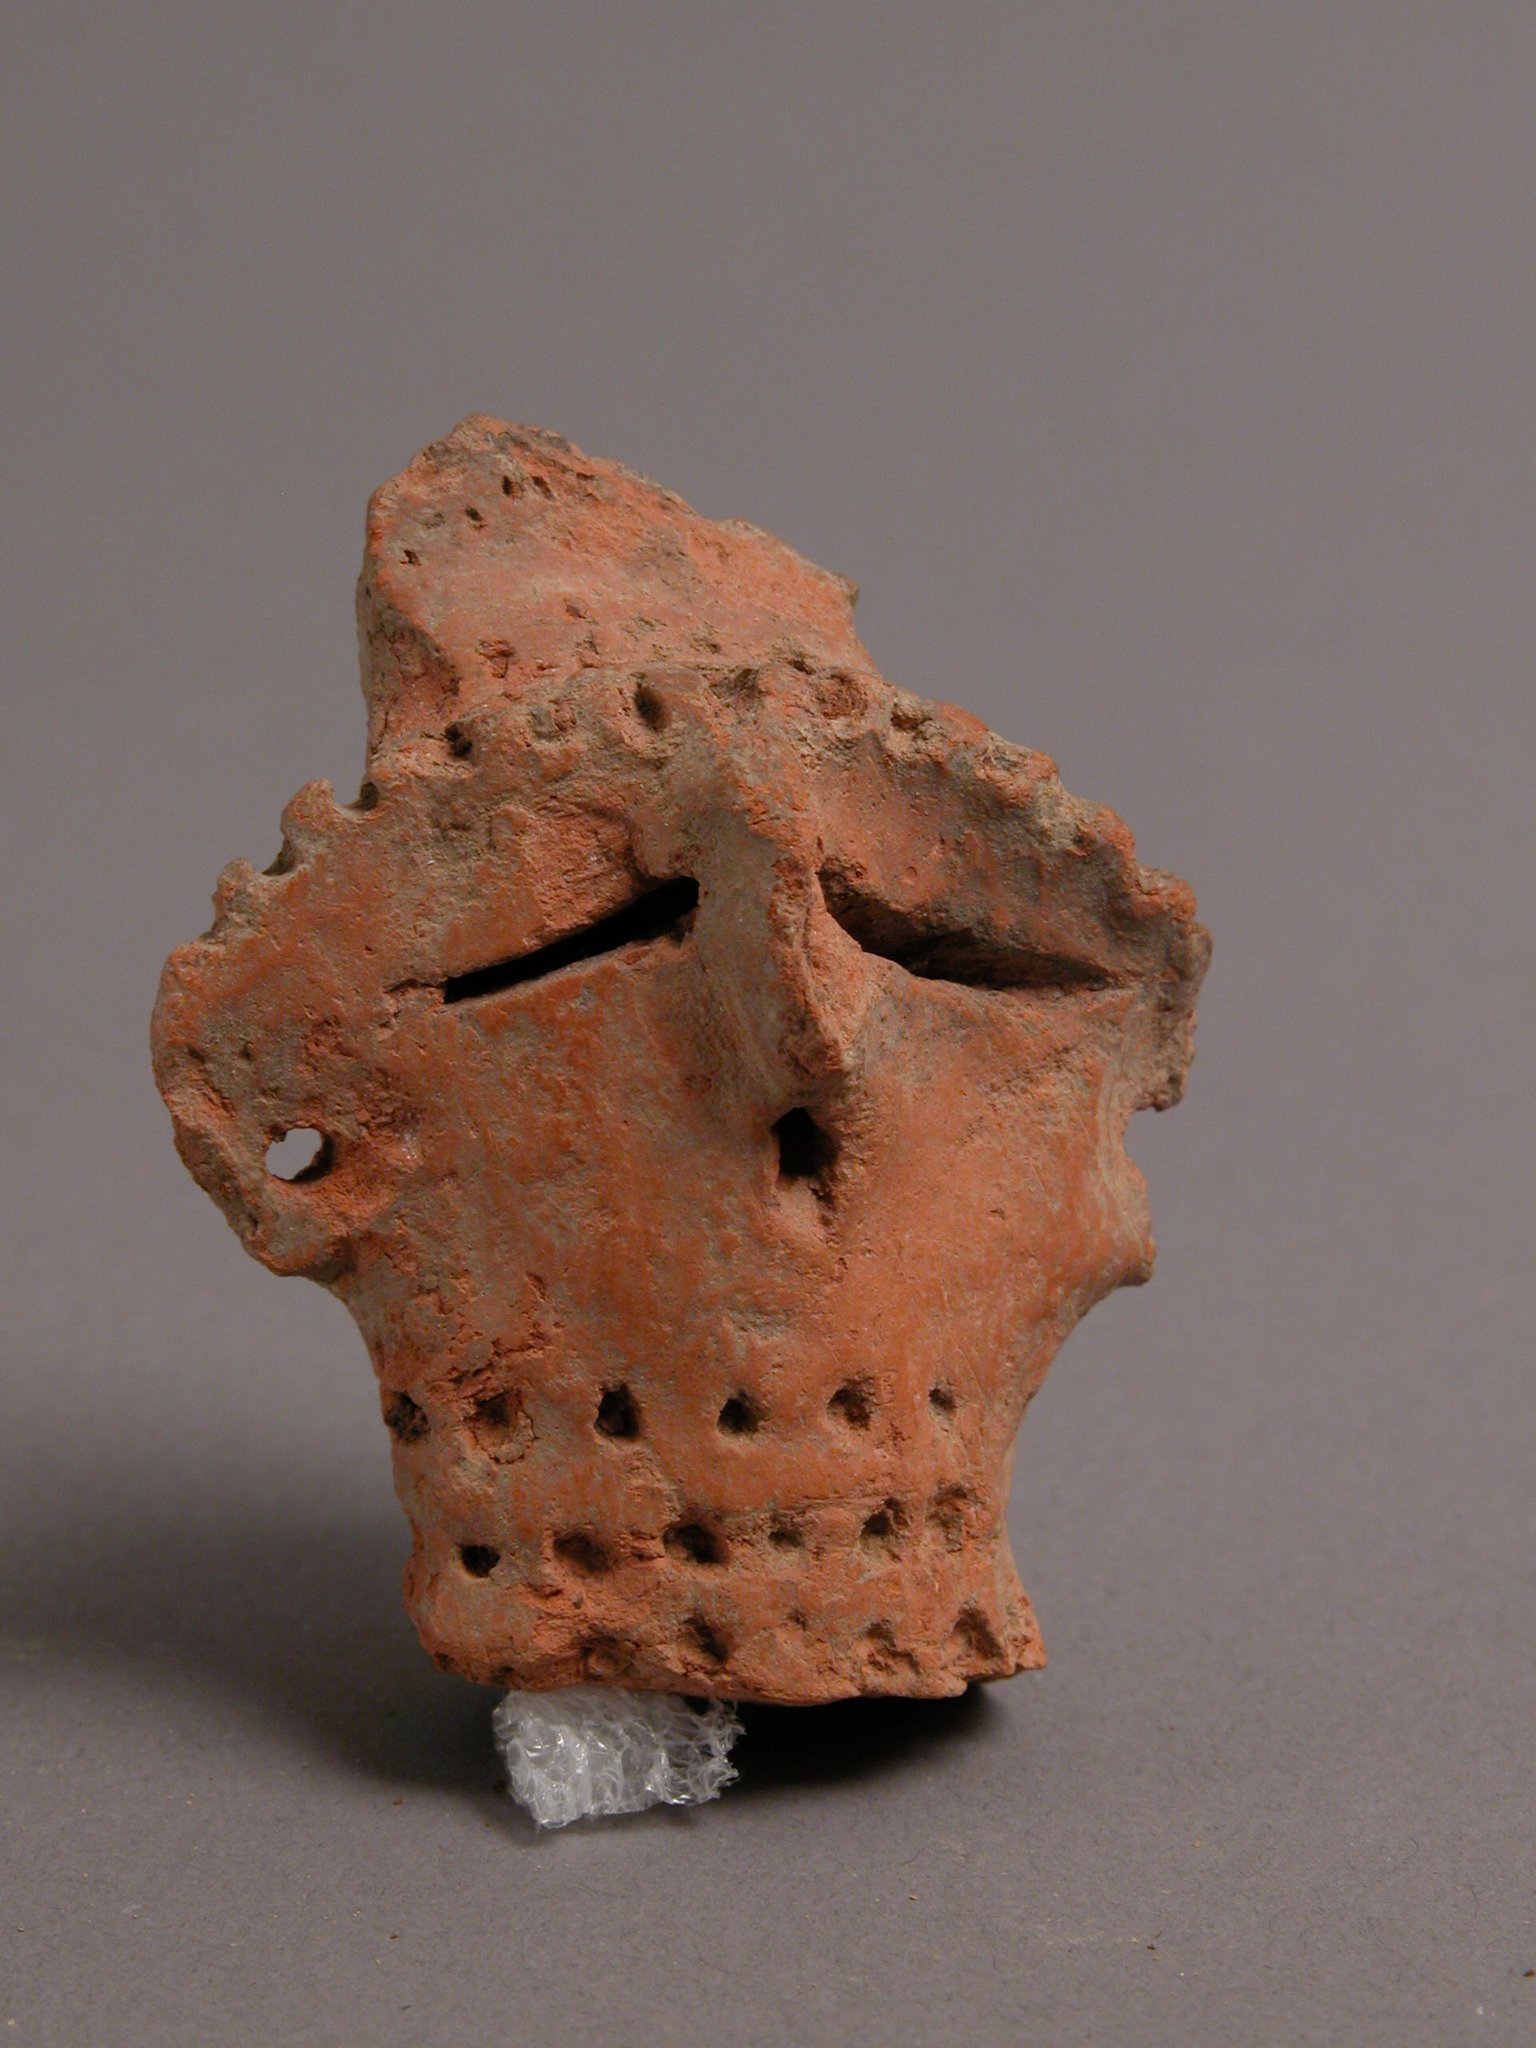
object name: statuette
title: Head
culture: coptic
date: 301-700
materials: earthenware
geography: egypt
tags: heads